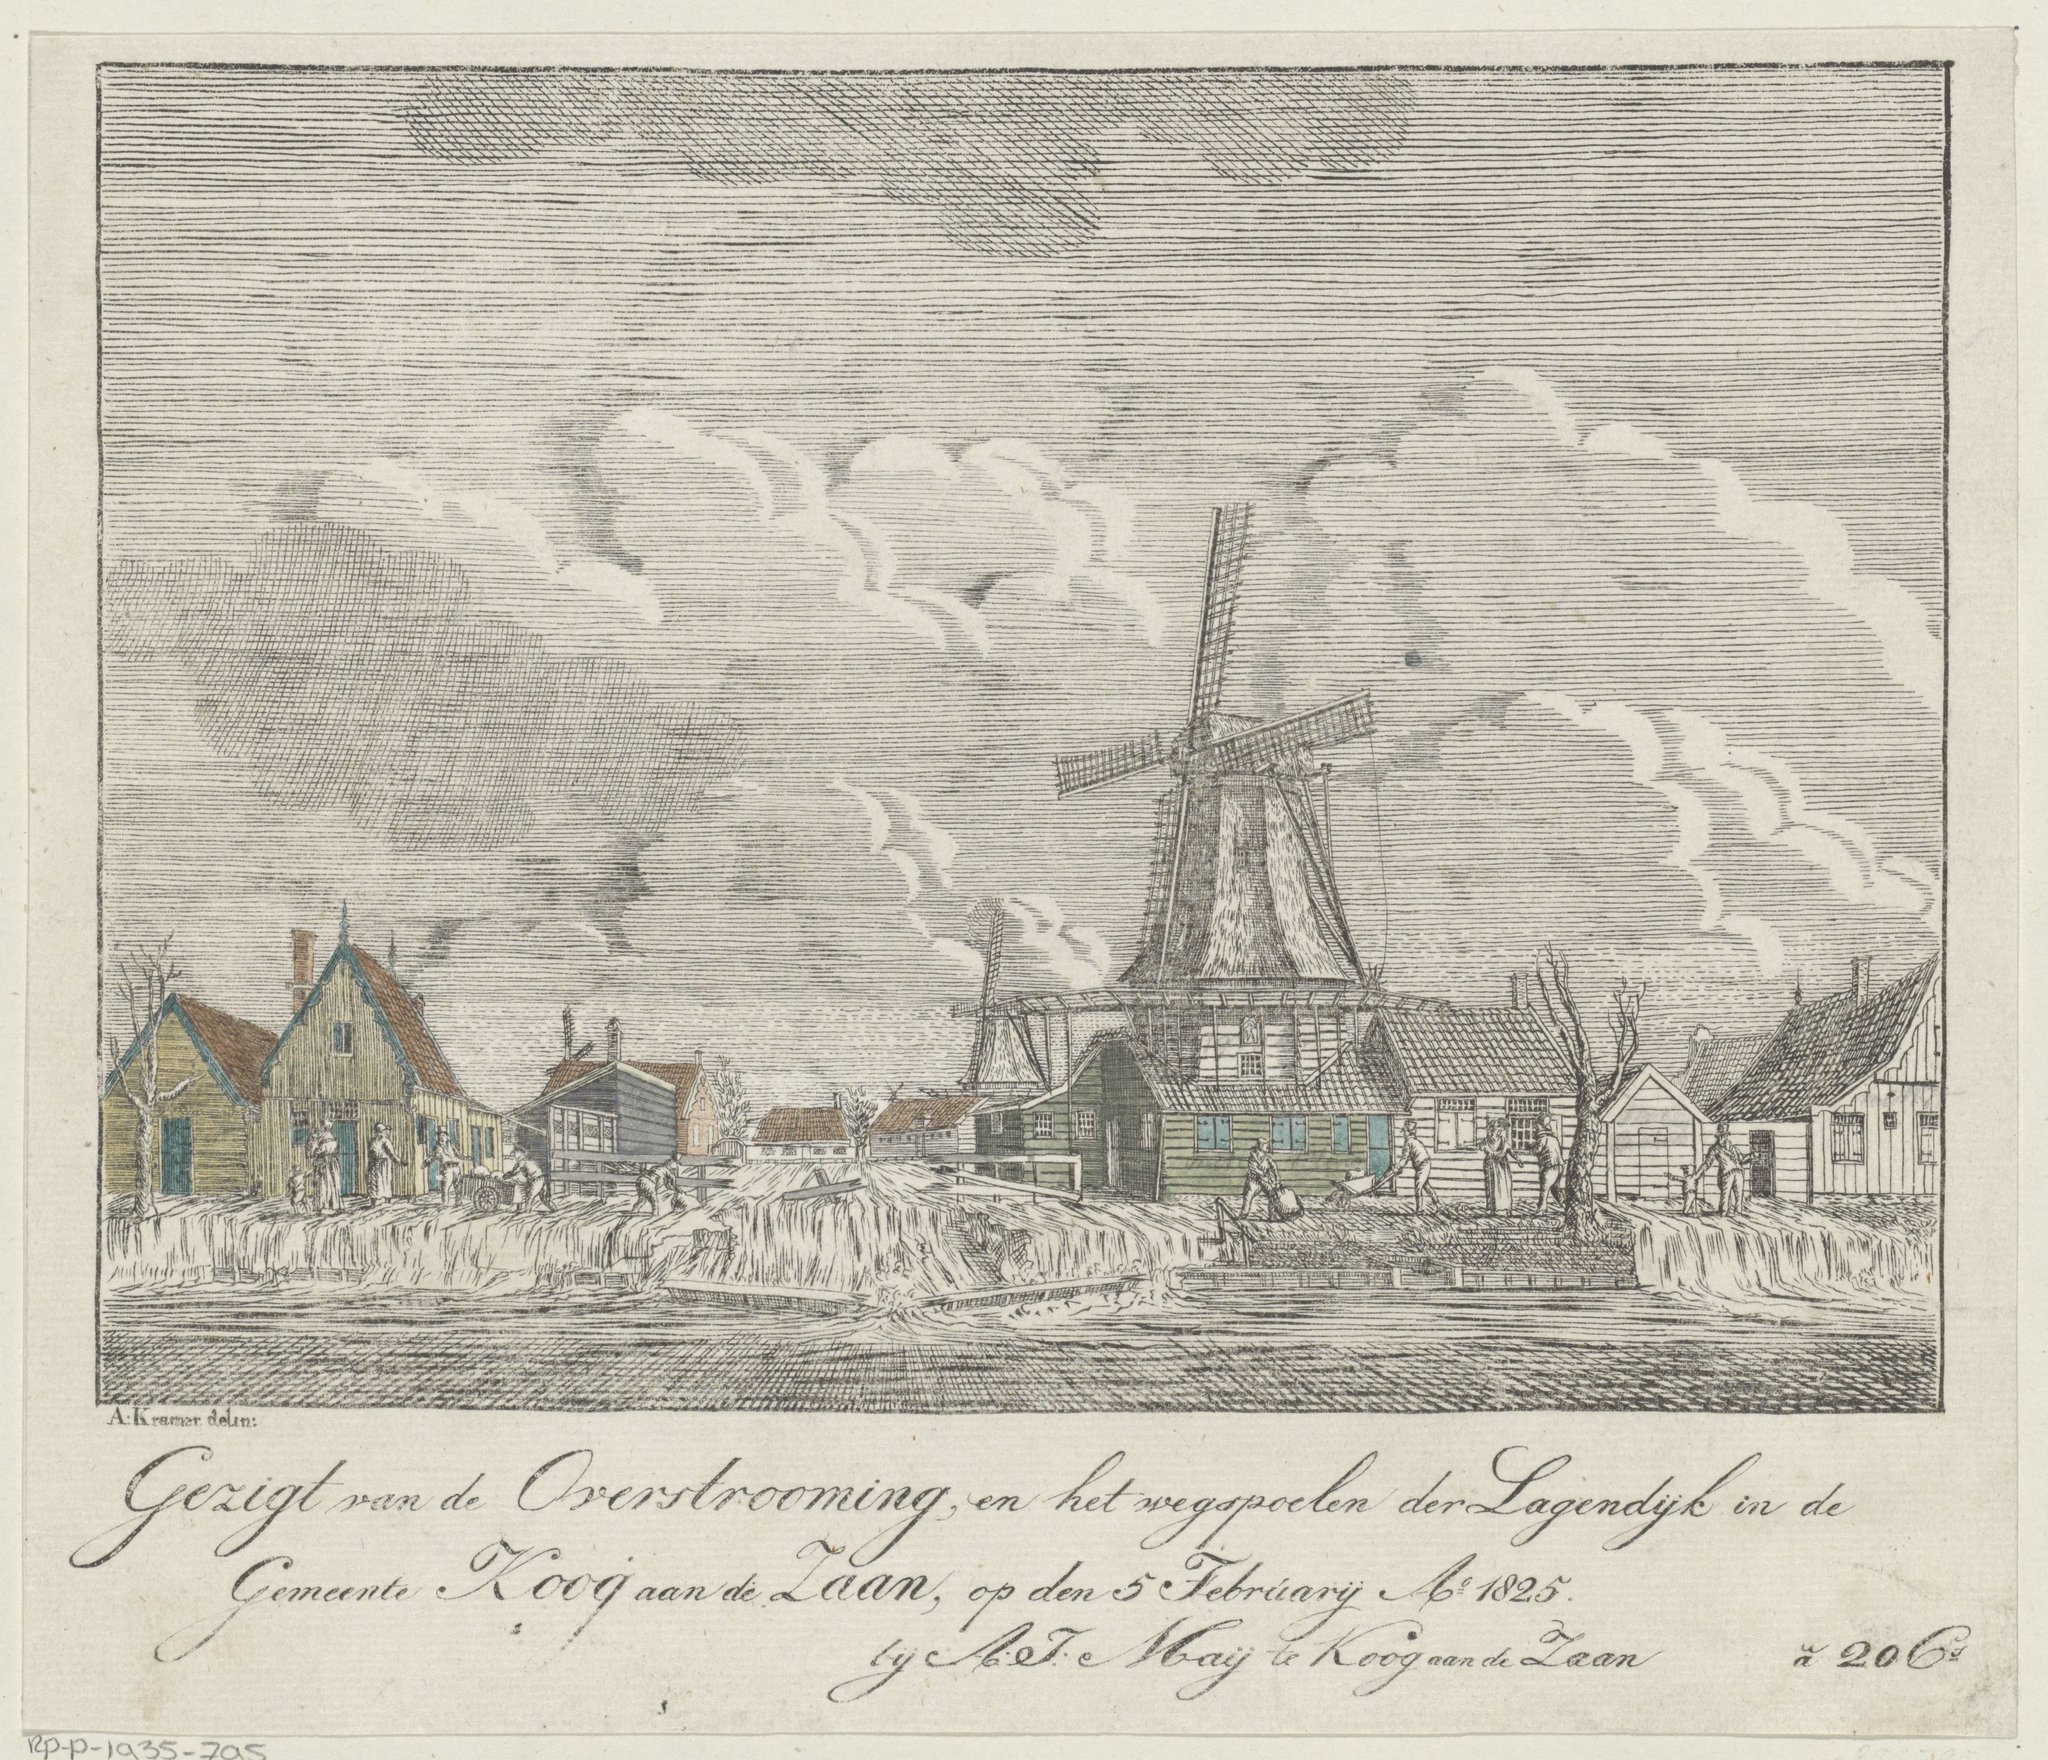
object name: print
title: Gezigt van de overstrooming en het wegspoelen der Lagendijk in de / gemeente Koog aan de Zaan, op den 5 february A 1825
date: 1825-1827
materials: paper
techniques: hand coloring, engraving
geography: netherlands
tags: flood, koog aan de zaan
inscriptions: collector's mark: Lugt 2228, collector's mark: Lugt 2760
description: Mannen en vrouwen plaatsen zandzakken om het stromende water tegen te houden dat de Lagedijk wegspoelt. Op de achtergrond staan houten huizen en een rieten molen.